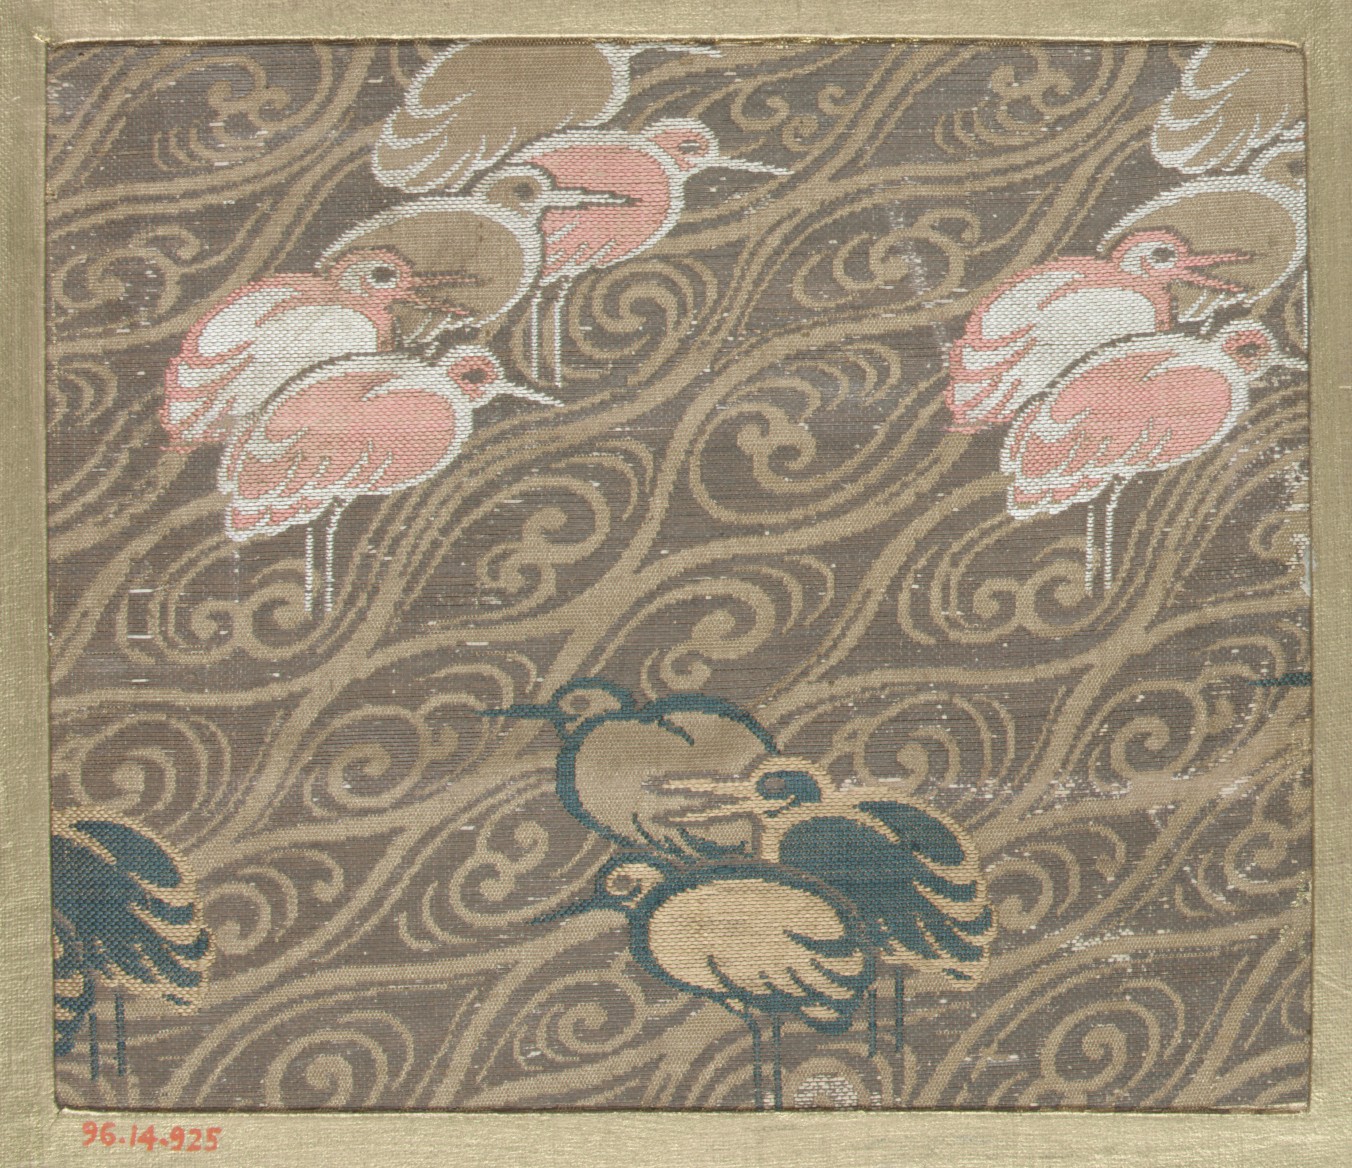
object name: piece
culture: japanese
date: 1801-1900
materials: silk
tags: birds